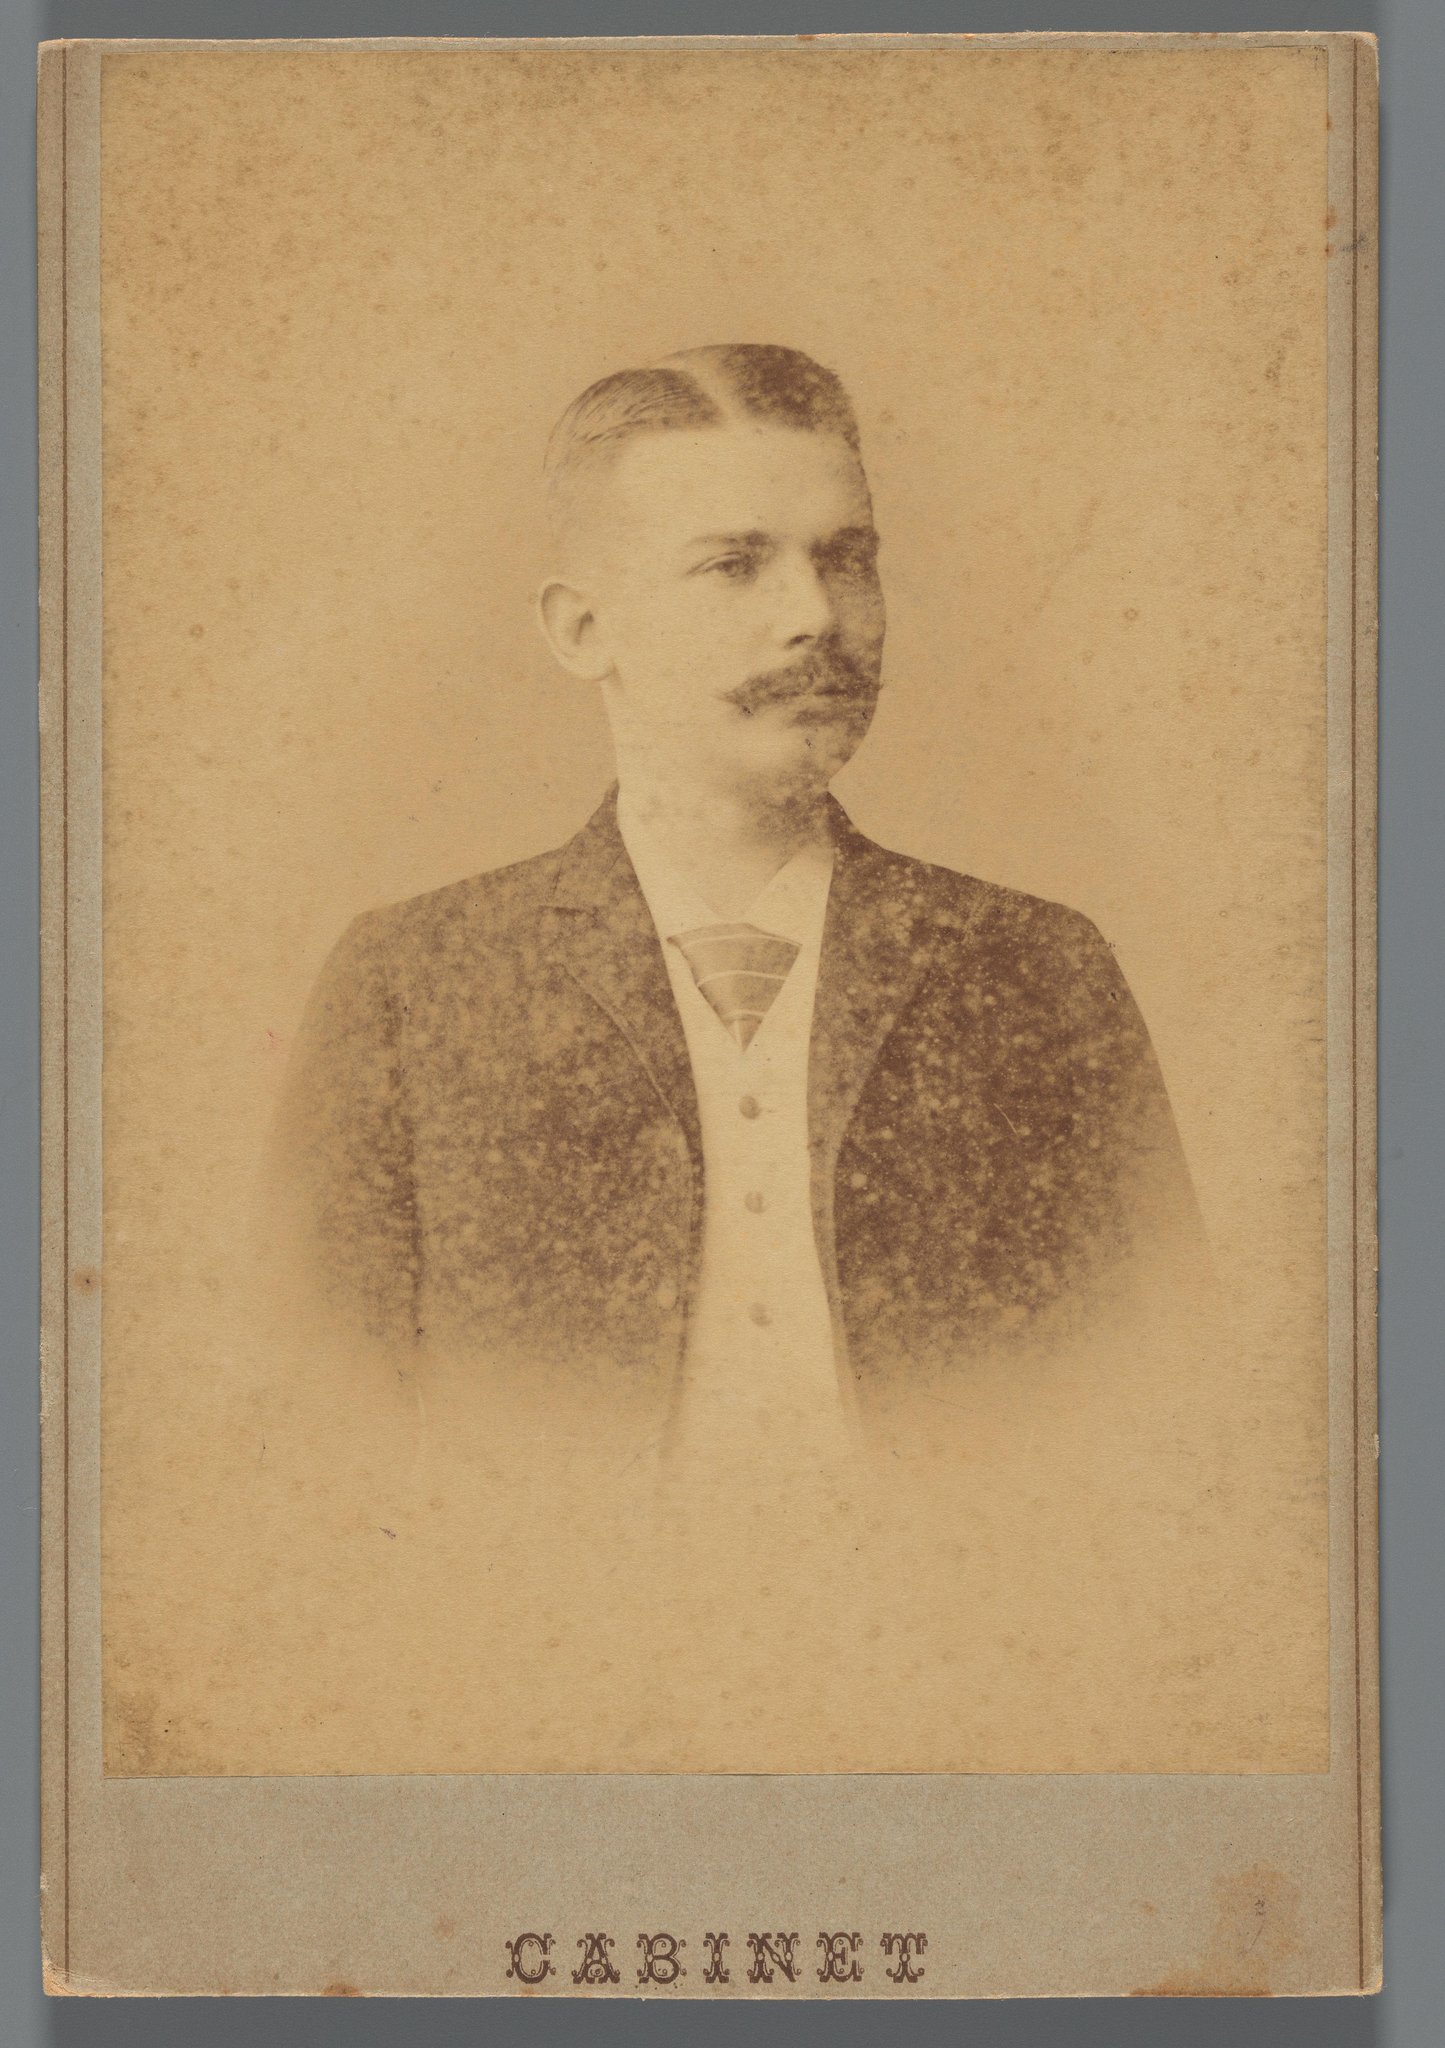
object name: cabinet photograph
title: Studioportret van Frans Alexander van den Berg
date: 1885-1899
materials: cardboard, photographic support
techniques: albumen print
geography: batavia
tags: batavia, frans alexander van den berg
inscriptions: name: ‘Photographisch Atelier / HERRMANN & Co. / BATAVIA / (OOST INDIË.)’, inscription: ‘CABINET’, name: ‘Frans van den Berg.’